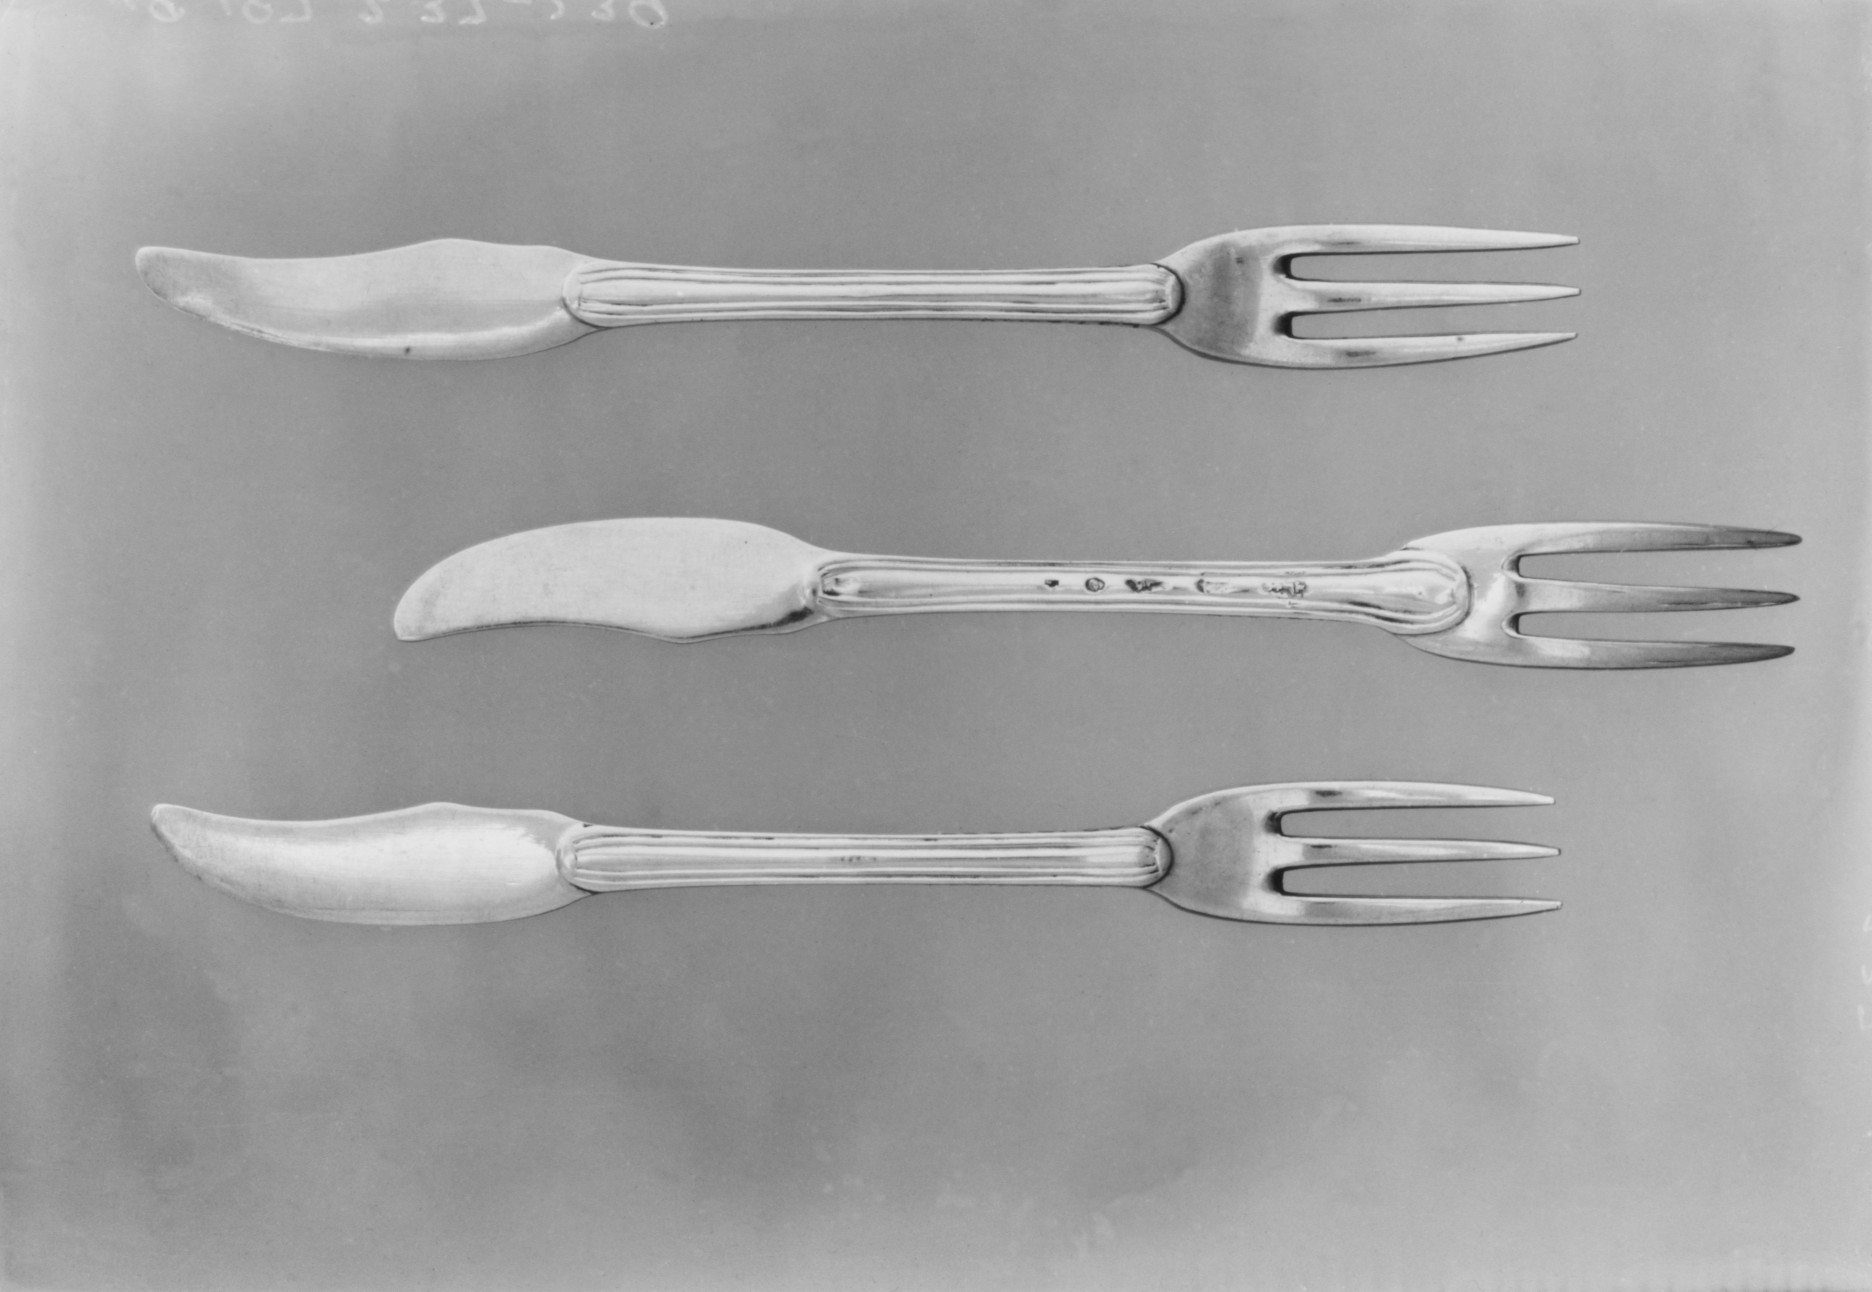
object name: fork with knife handle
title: Fork with knife handle (one of six)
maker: louis-antoine taillepied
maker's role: maker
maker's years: 1734-1834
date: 1778-1779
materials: silver